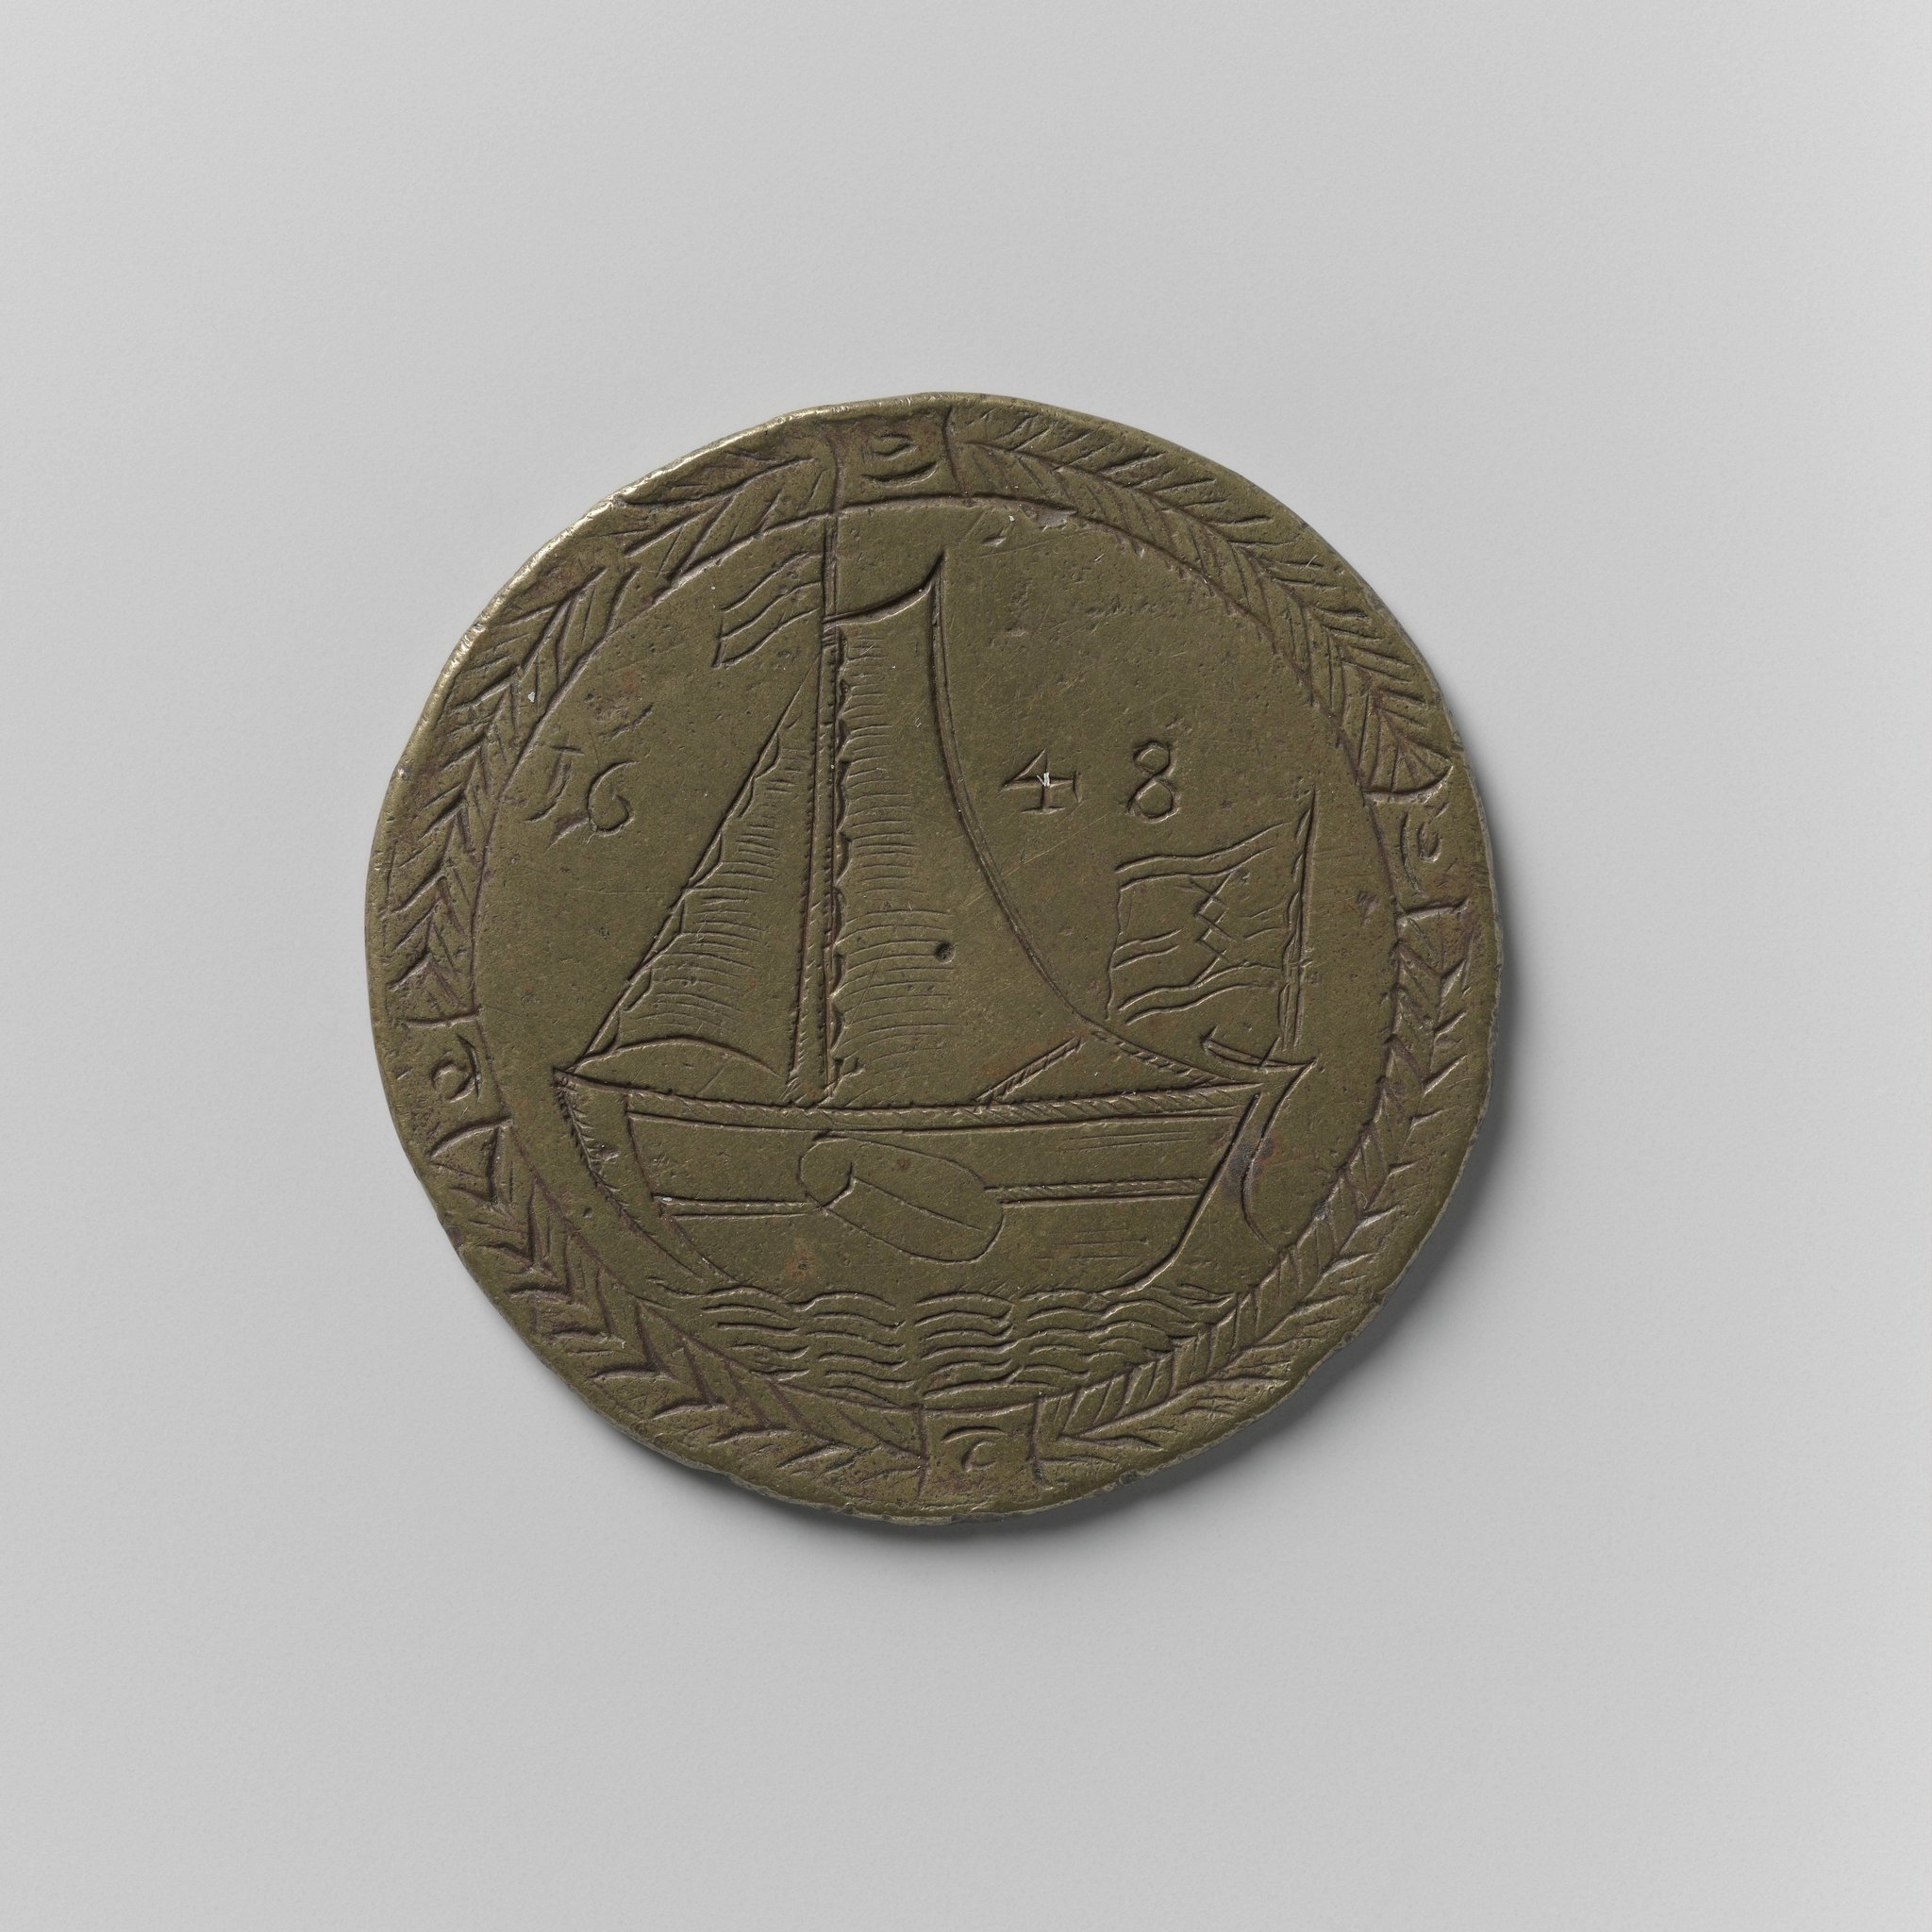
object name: medal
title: Roei-, steiger- en schuitenvoerdersgilde van Amsterdam, gildepenning van Verret de Boer, ligplaats Harlinger steiger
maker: Anonymous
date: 1648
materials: brass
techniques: engraving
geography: amsterdam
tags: amsterdam